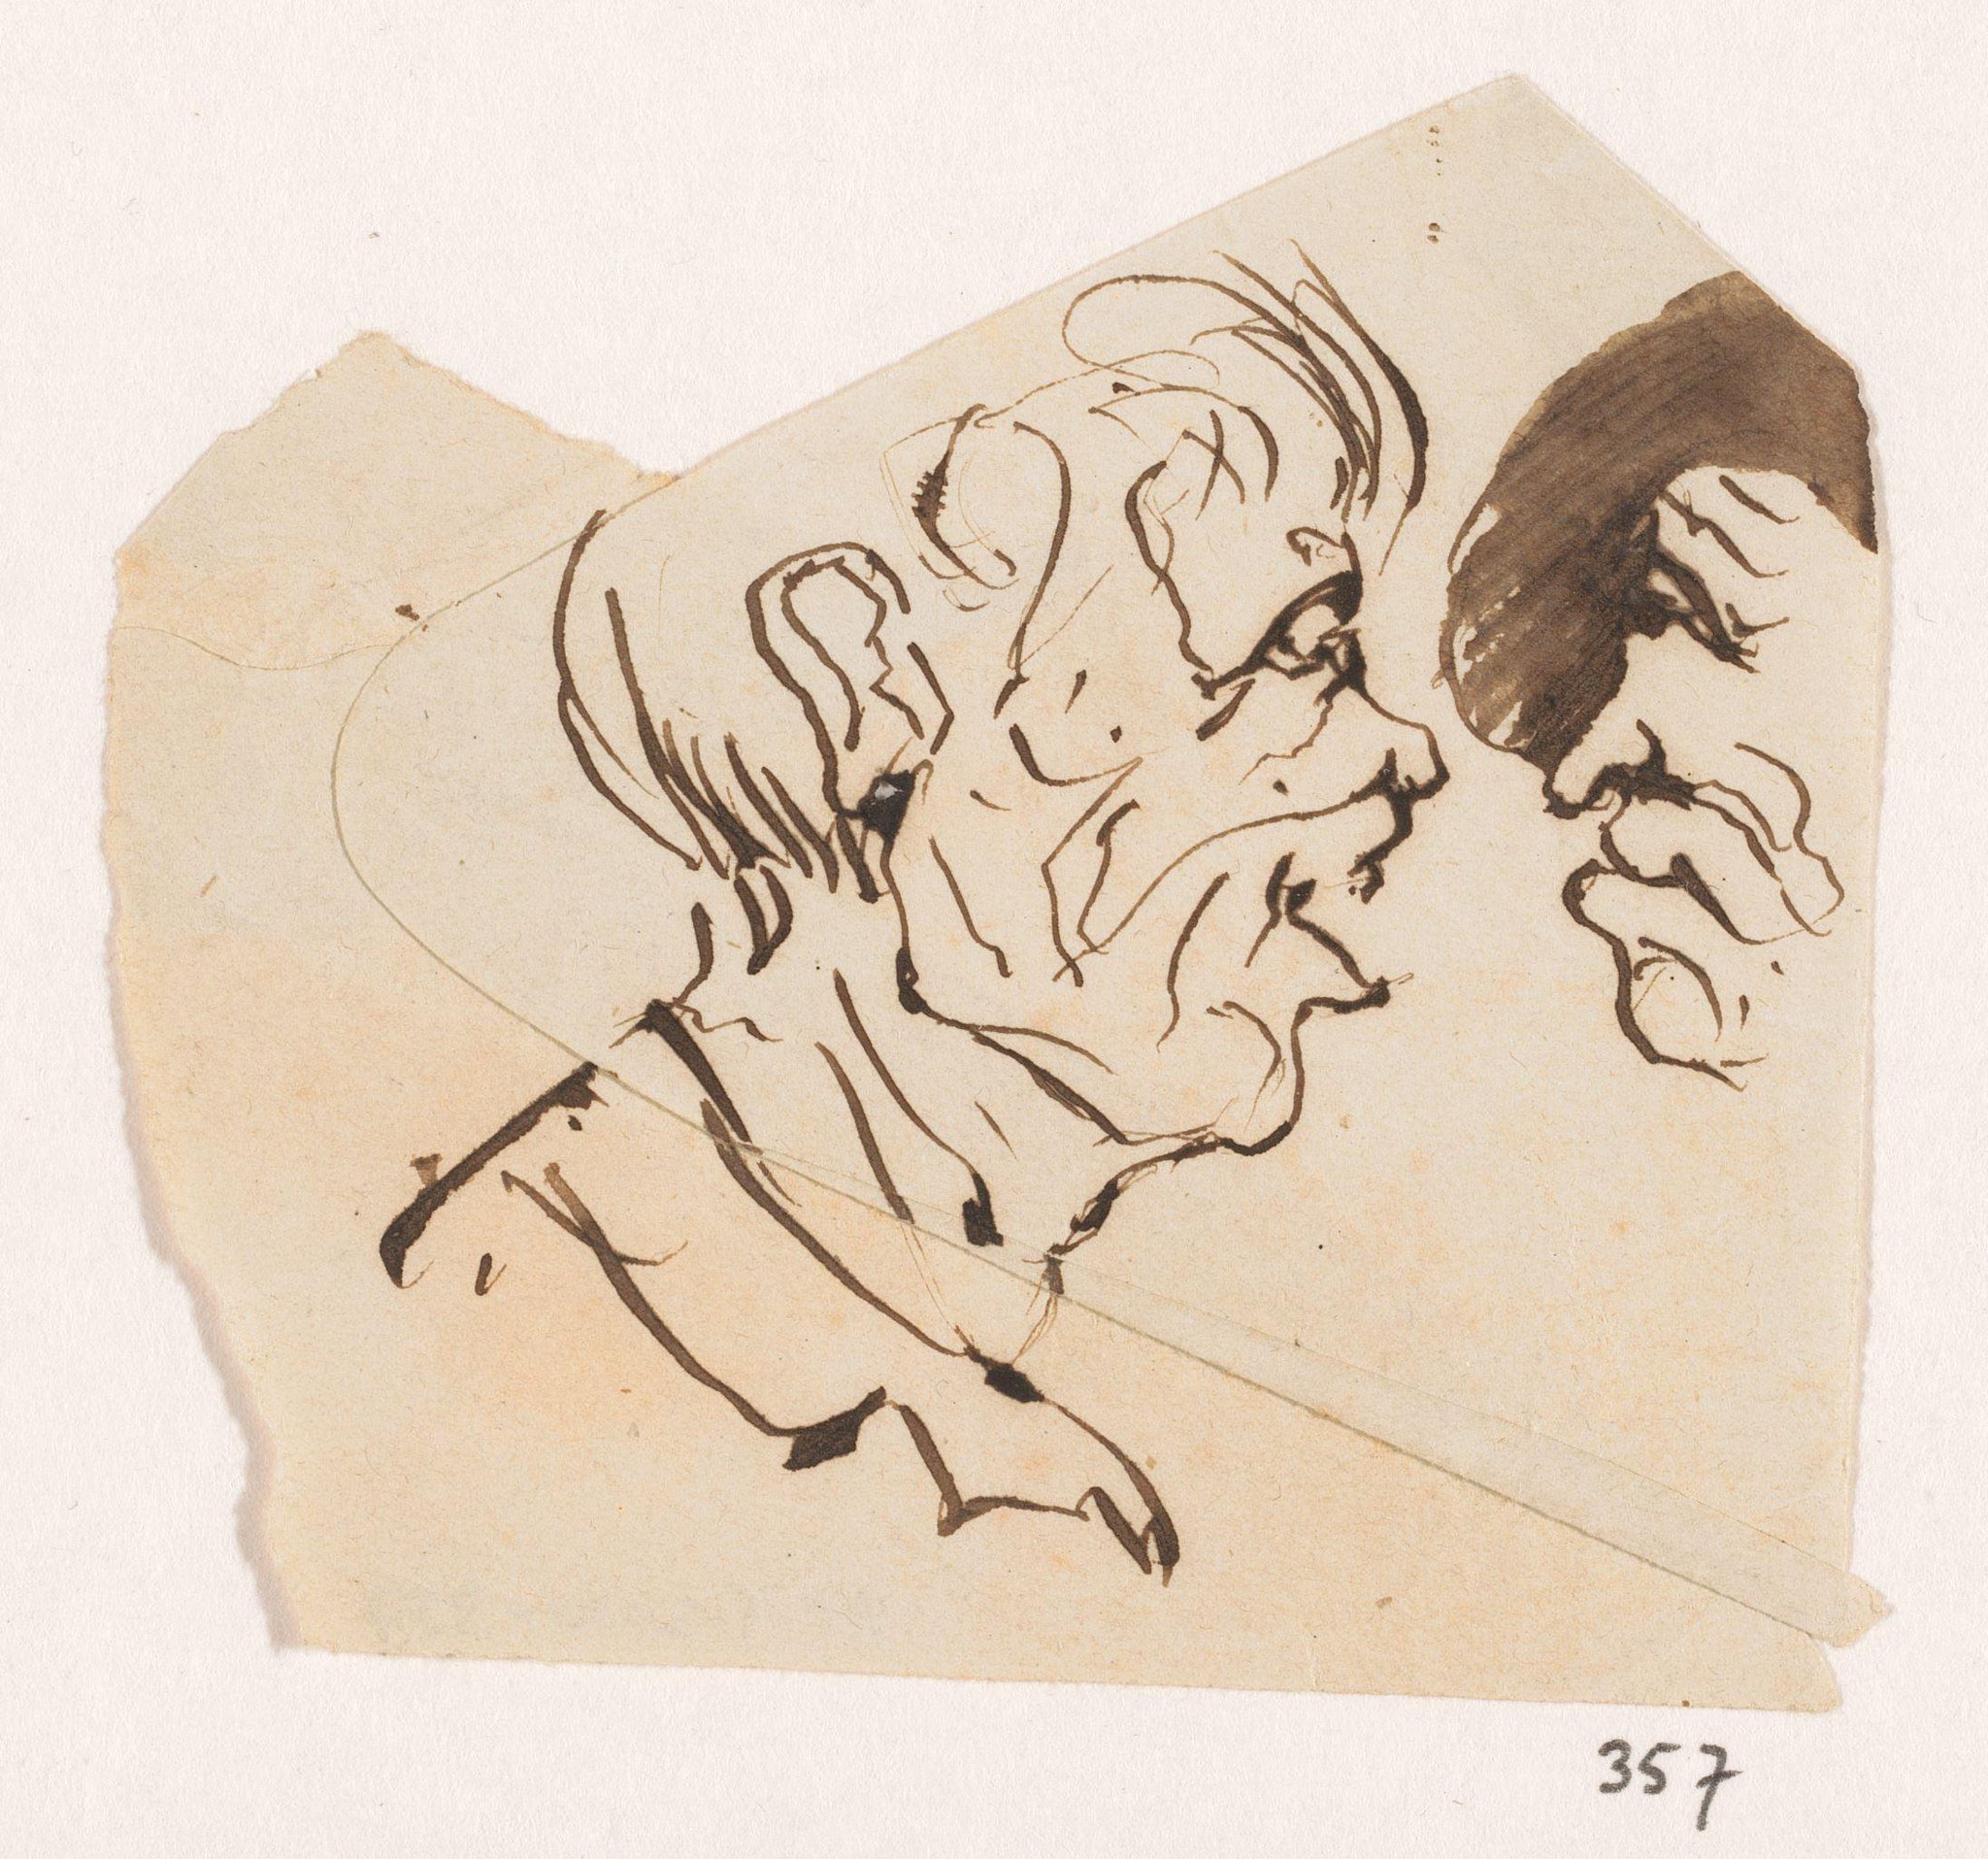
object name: drawing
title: Koppen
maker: johannes tavenraat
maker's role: draughtsman, painter, print maker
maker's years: 1809-1881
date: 1840-1880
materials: ink, paper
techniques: pen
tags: caricatures (human types)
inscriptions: collector's mark: Lugt 2228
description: Koppen. Getekend op een fragment van een envelop.